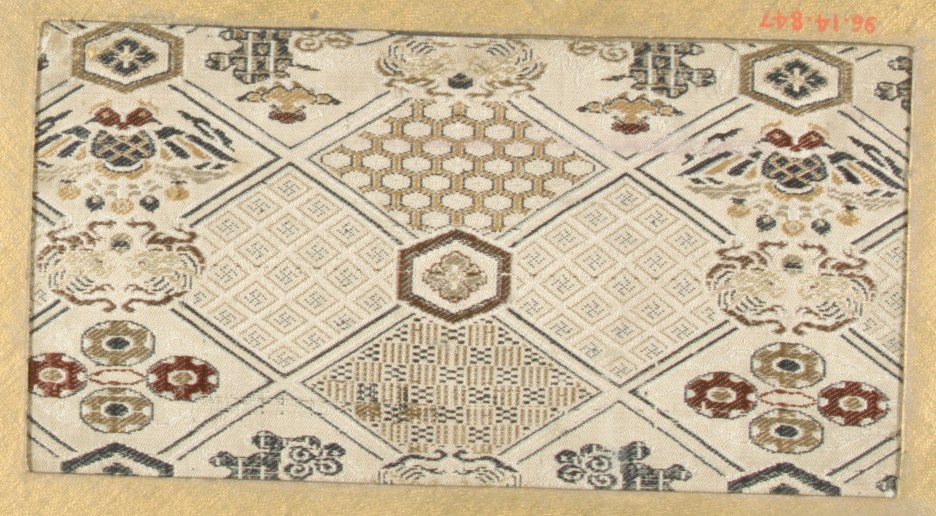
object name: piece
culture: japanese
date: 1701-1900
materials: silk